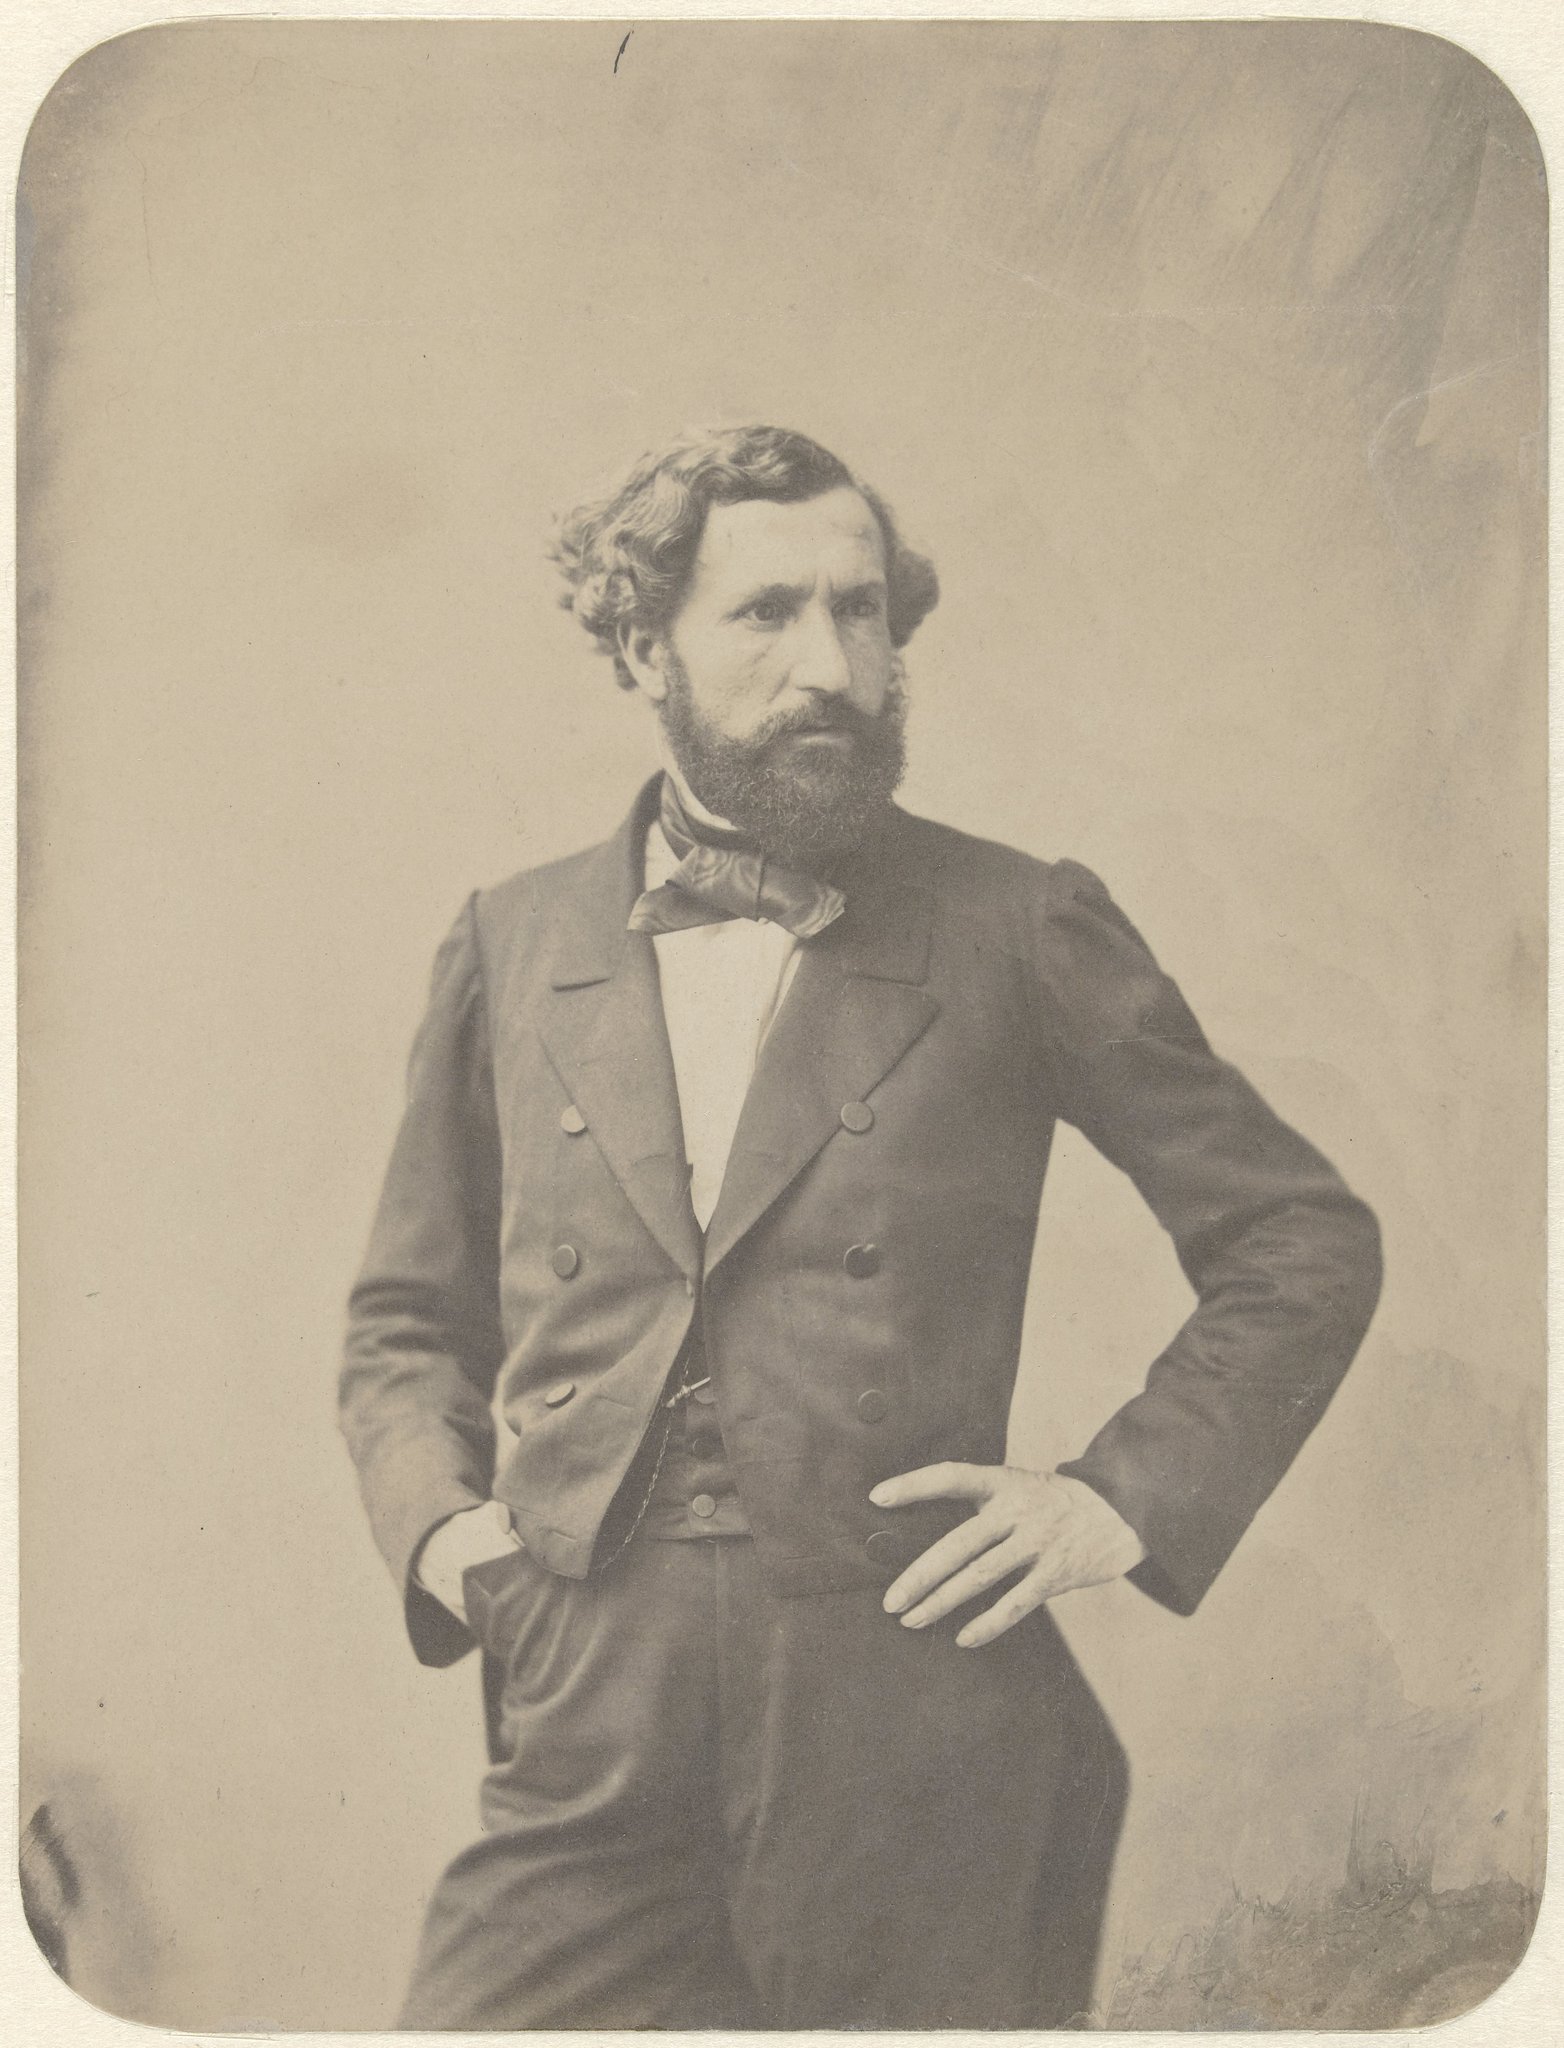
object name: photograph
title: Portret van een onbekende man met hand in de zij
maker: pierre petit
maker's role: fotograaf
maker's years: 1832-1909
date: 1855-1860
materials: paper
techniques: salted paper print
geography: paris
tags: historical persons not known by name, paris